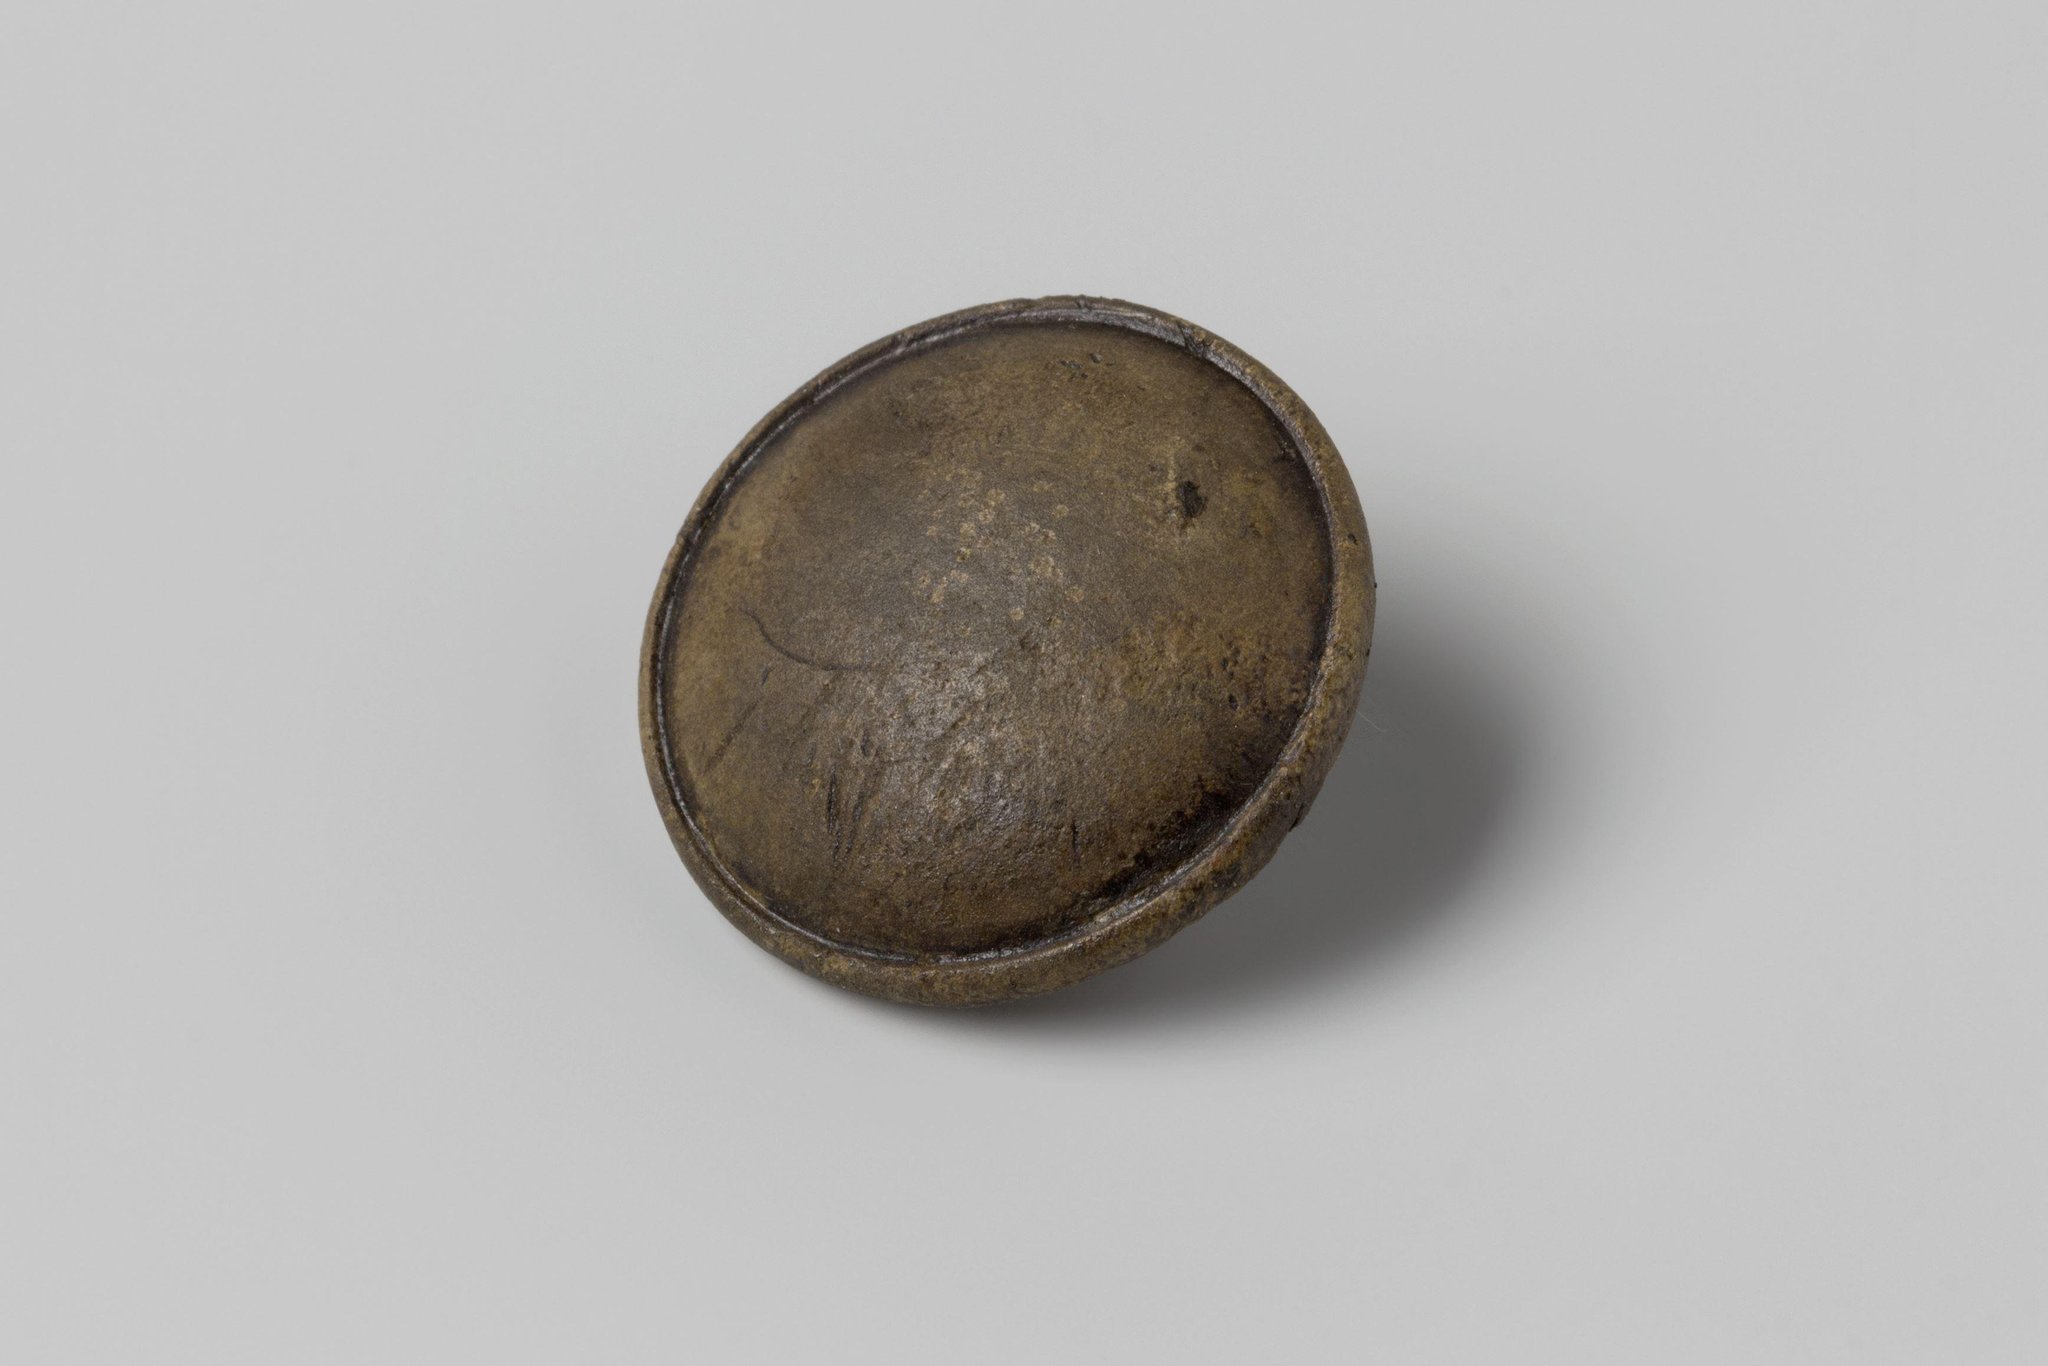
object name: button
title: Knoop uit het wrak van de Oost-Indiëvaarder Hollandia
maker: Anonymous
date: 1700-1743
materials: bone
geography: netherlands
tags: verenigde oostindische compagnie, hollandia (schip), annet